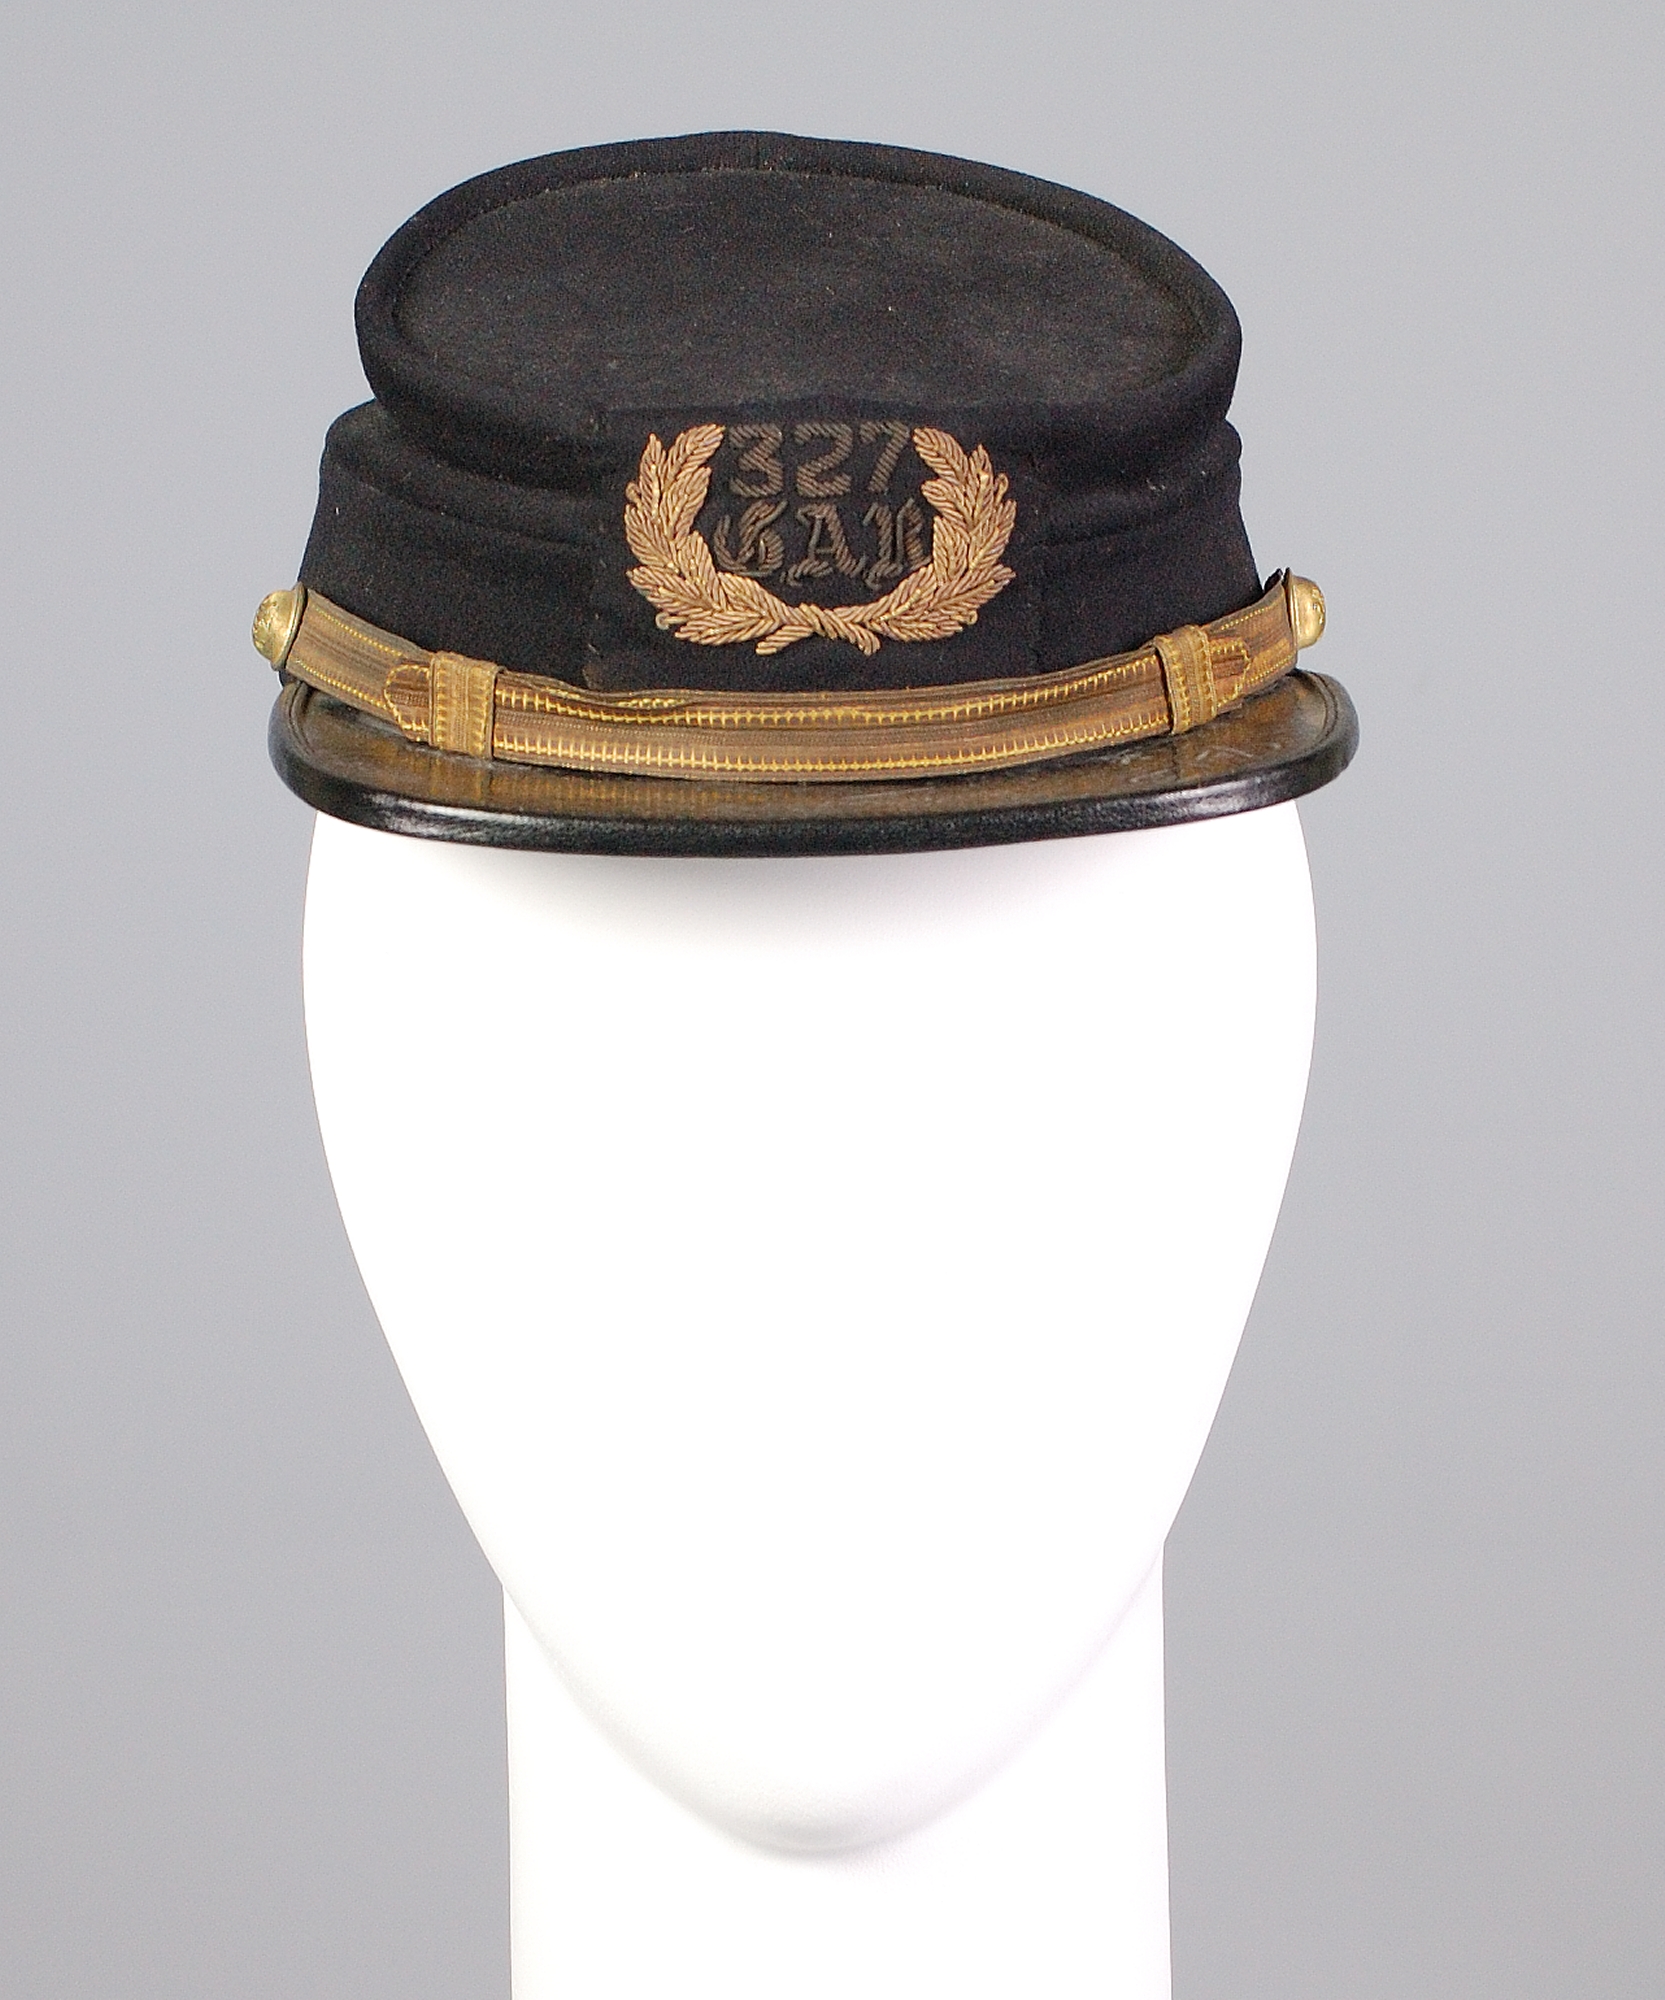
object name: cap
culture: american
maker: balch, price & company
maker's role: department store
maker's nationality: american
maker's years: 1869-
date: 1890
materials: wool